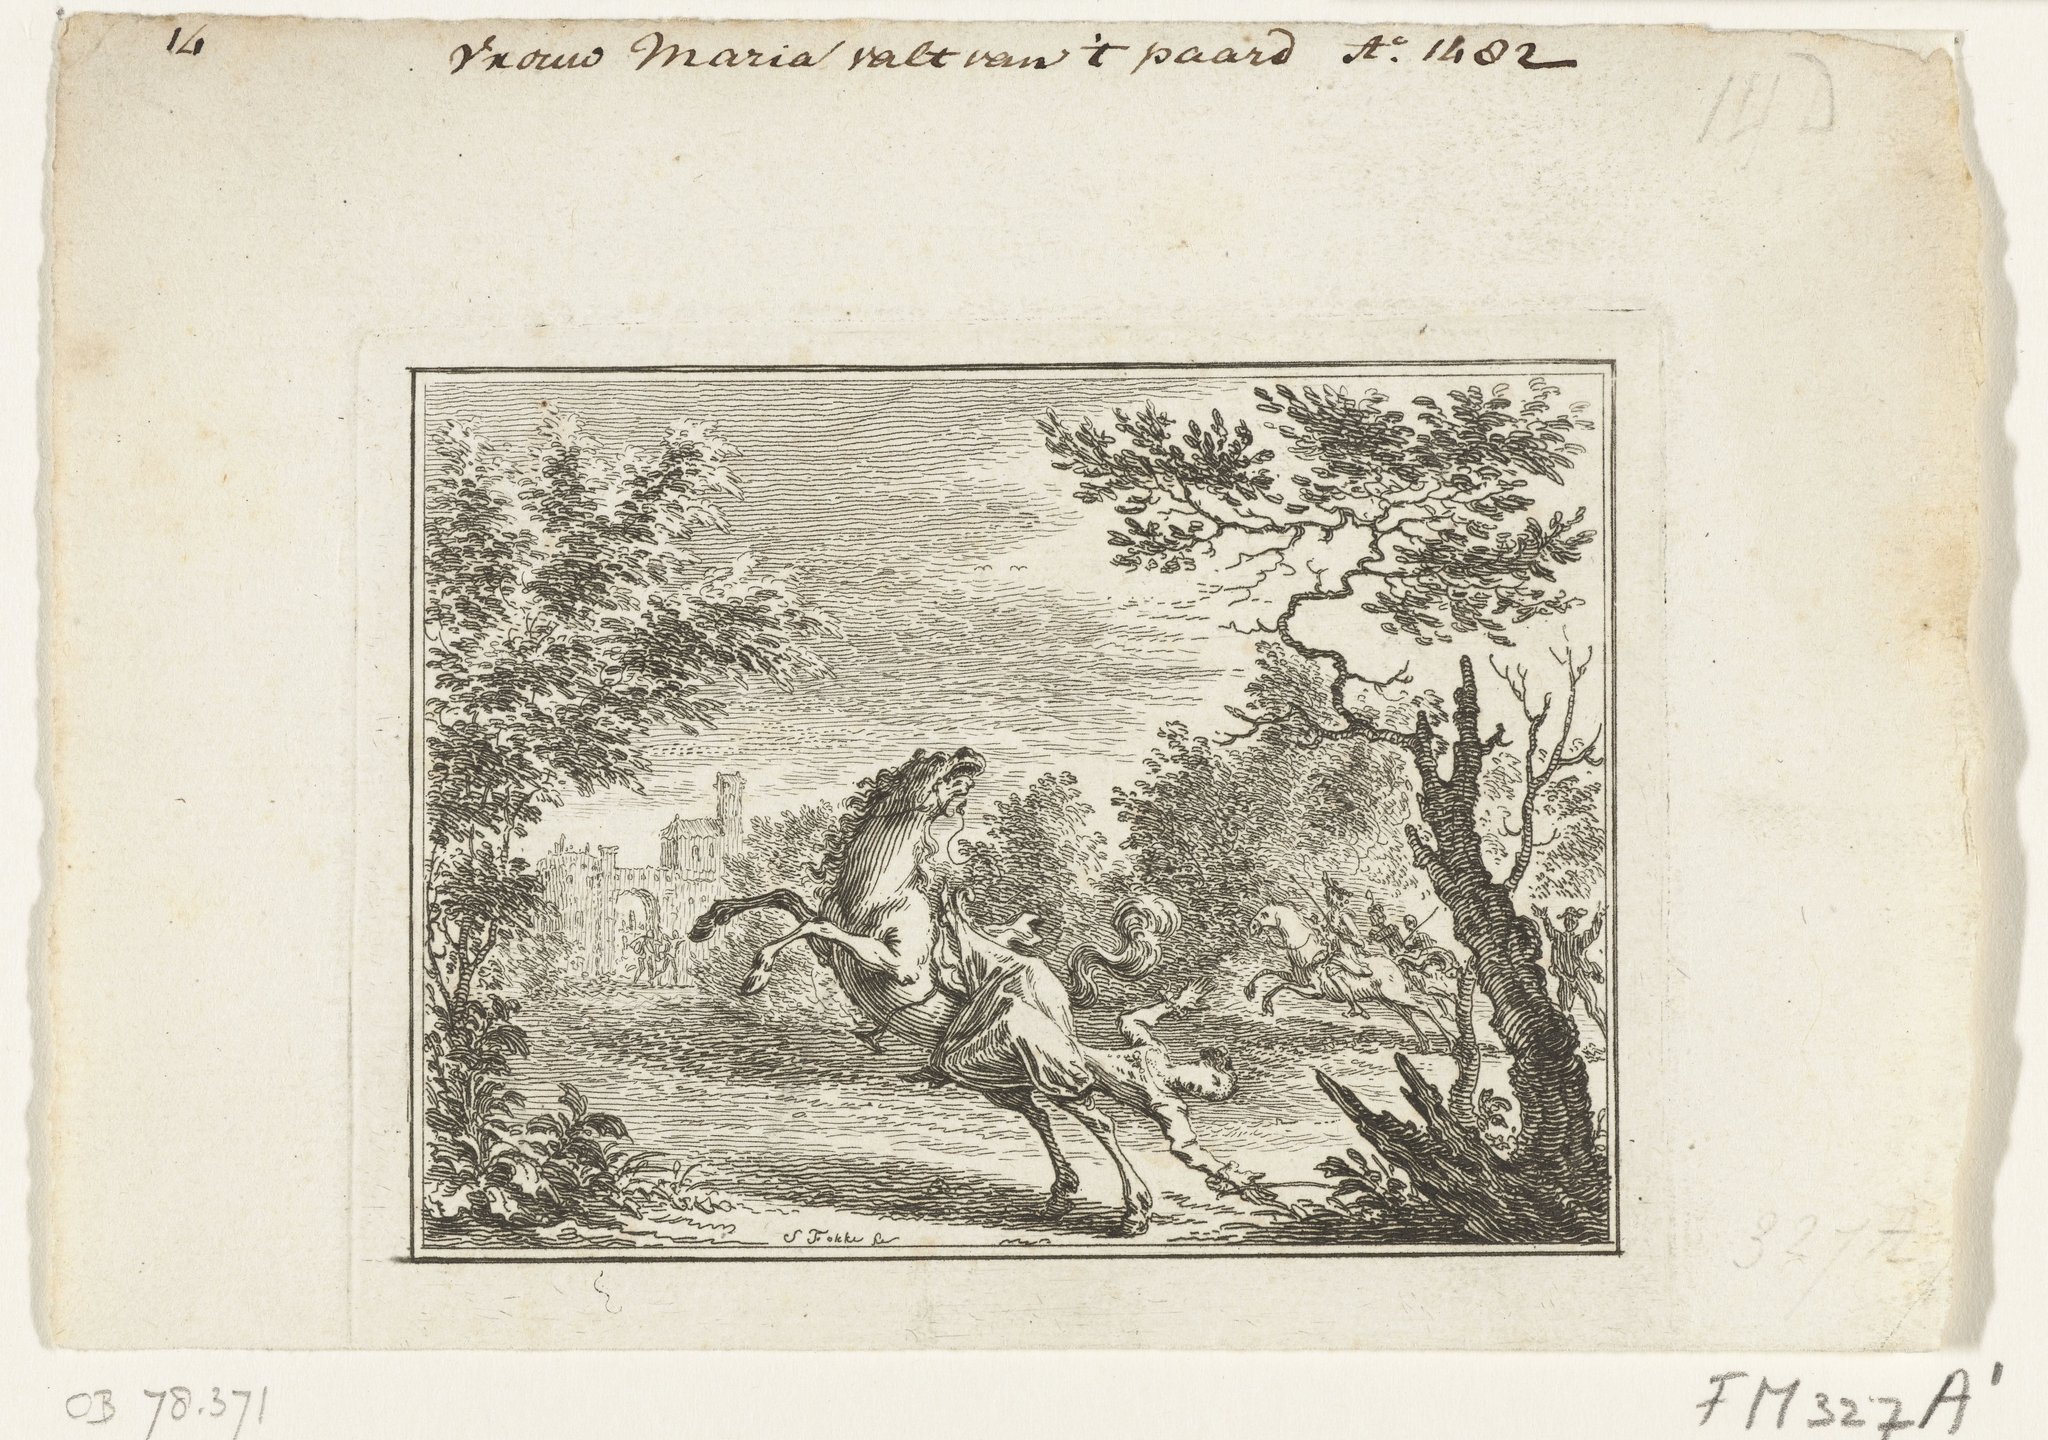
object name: print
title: Maria van Bourgondië valt van haar paard, 1482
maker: simon fokke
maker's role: draughtsman, print maker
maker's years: 1712-1784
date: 1782-1784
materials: paper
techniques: etching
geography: northern netherlands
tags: maria (hertogin van bourgondië), dying from the effects of a fall, bruges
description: Illustratie voor: J.W. te Water, De vaderlandsche Historie van den heere J. Wagenaar, verkort, en met leerzaame aanmerkingen, ten dienste der Nederlandsche jeugd, 1784-1800, 4 delen.